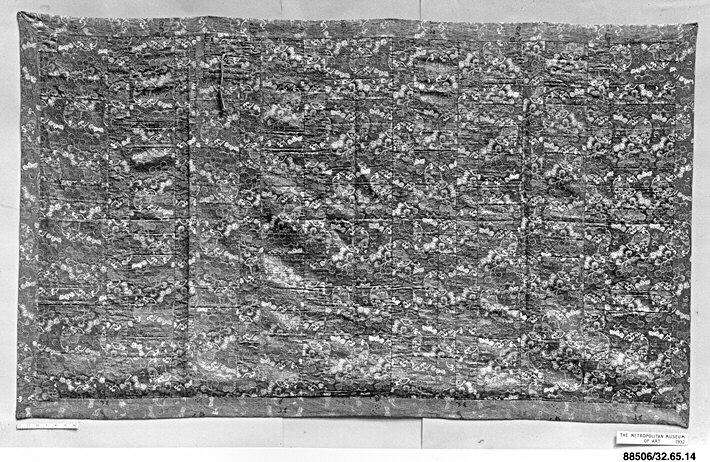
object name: robe, priest's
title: Priest's Robe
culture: japanese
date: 1801-1833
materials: silk